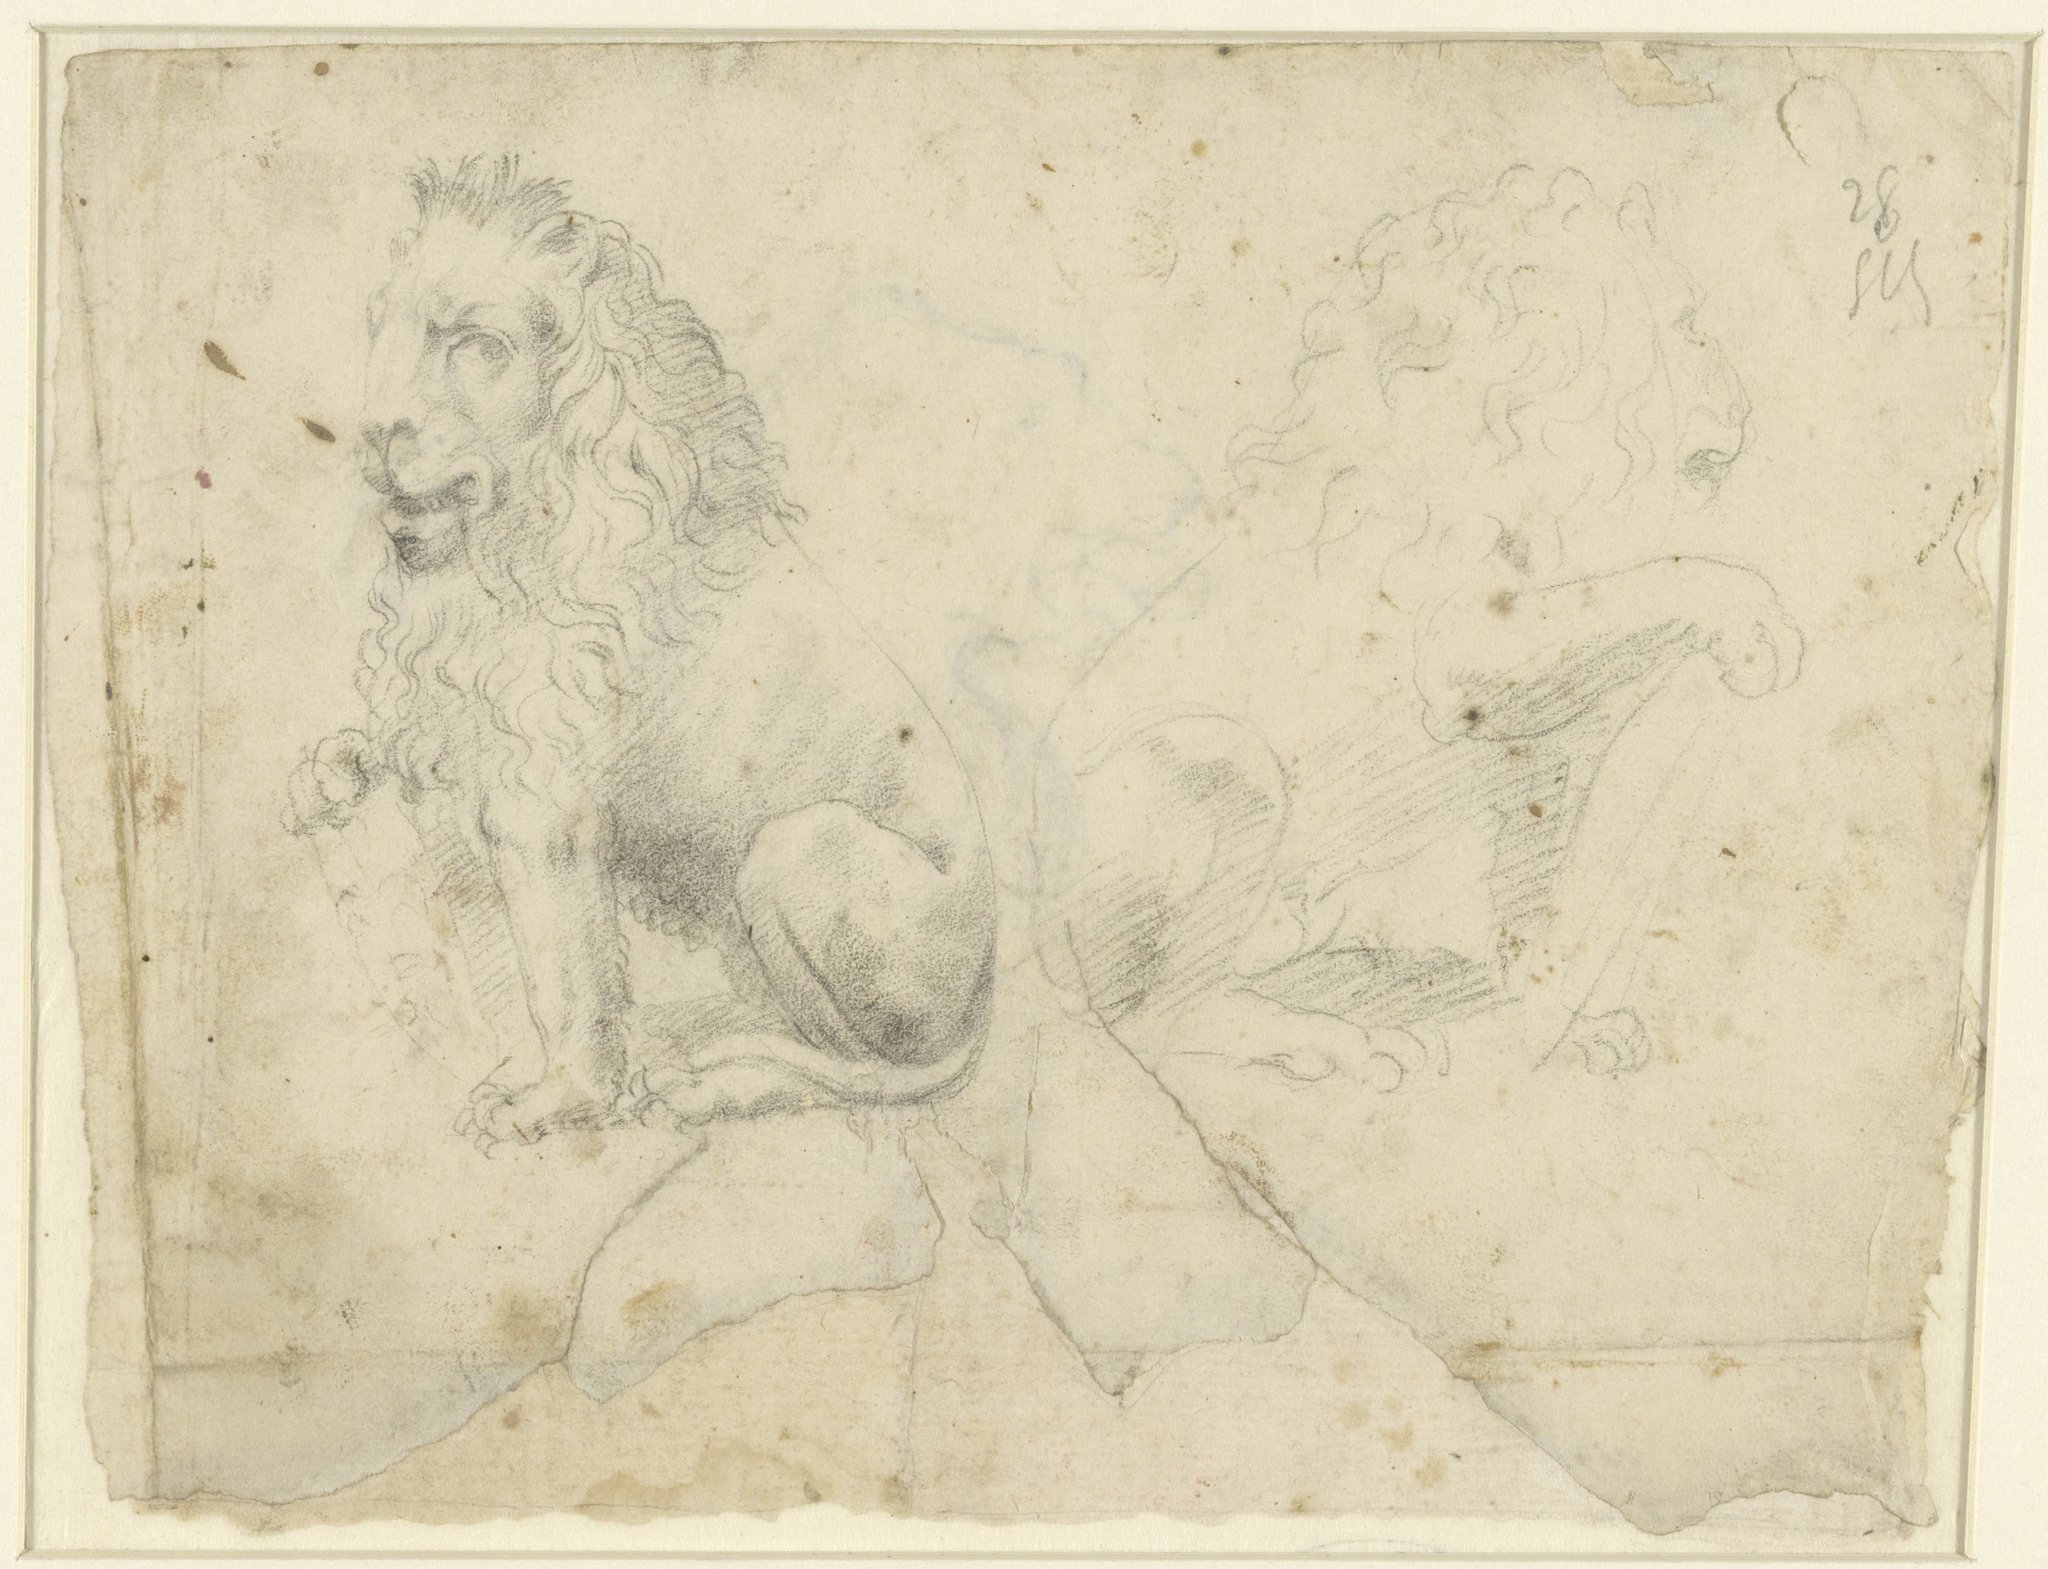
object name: drawing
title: Twee studies naar een beeld van een leeuw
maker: Anonymous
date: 1480-1520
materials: chalk, paper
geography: florence